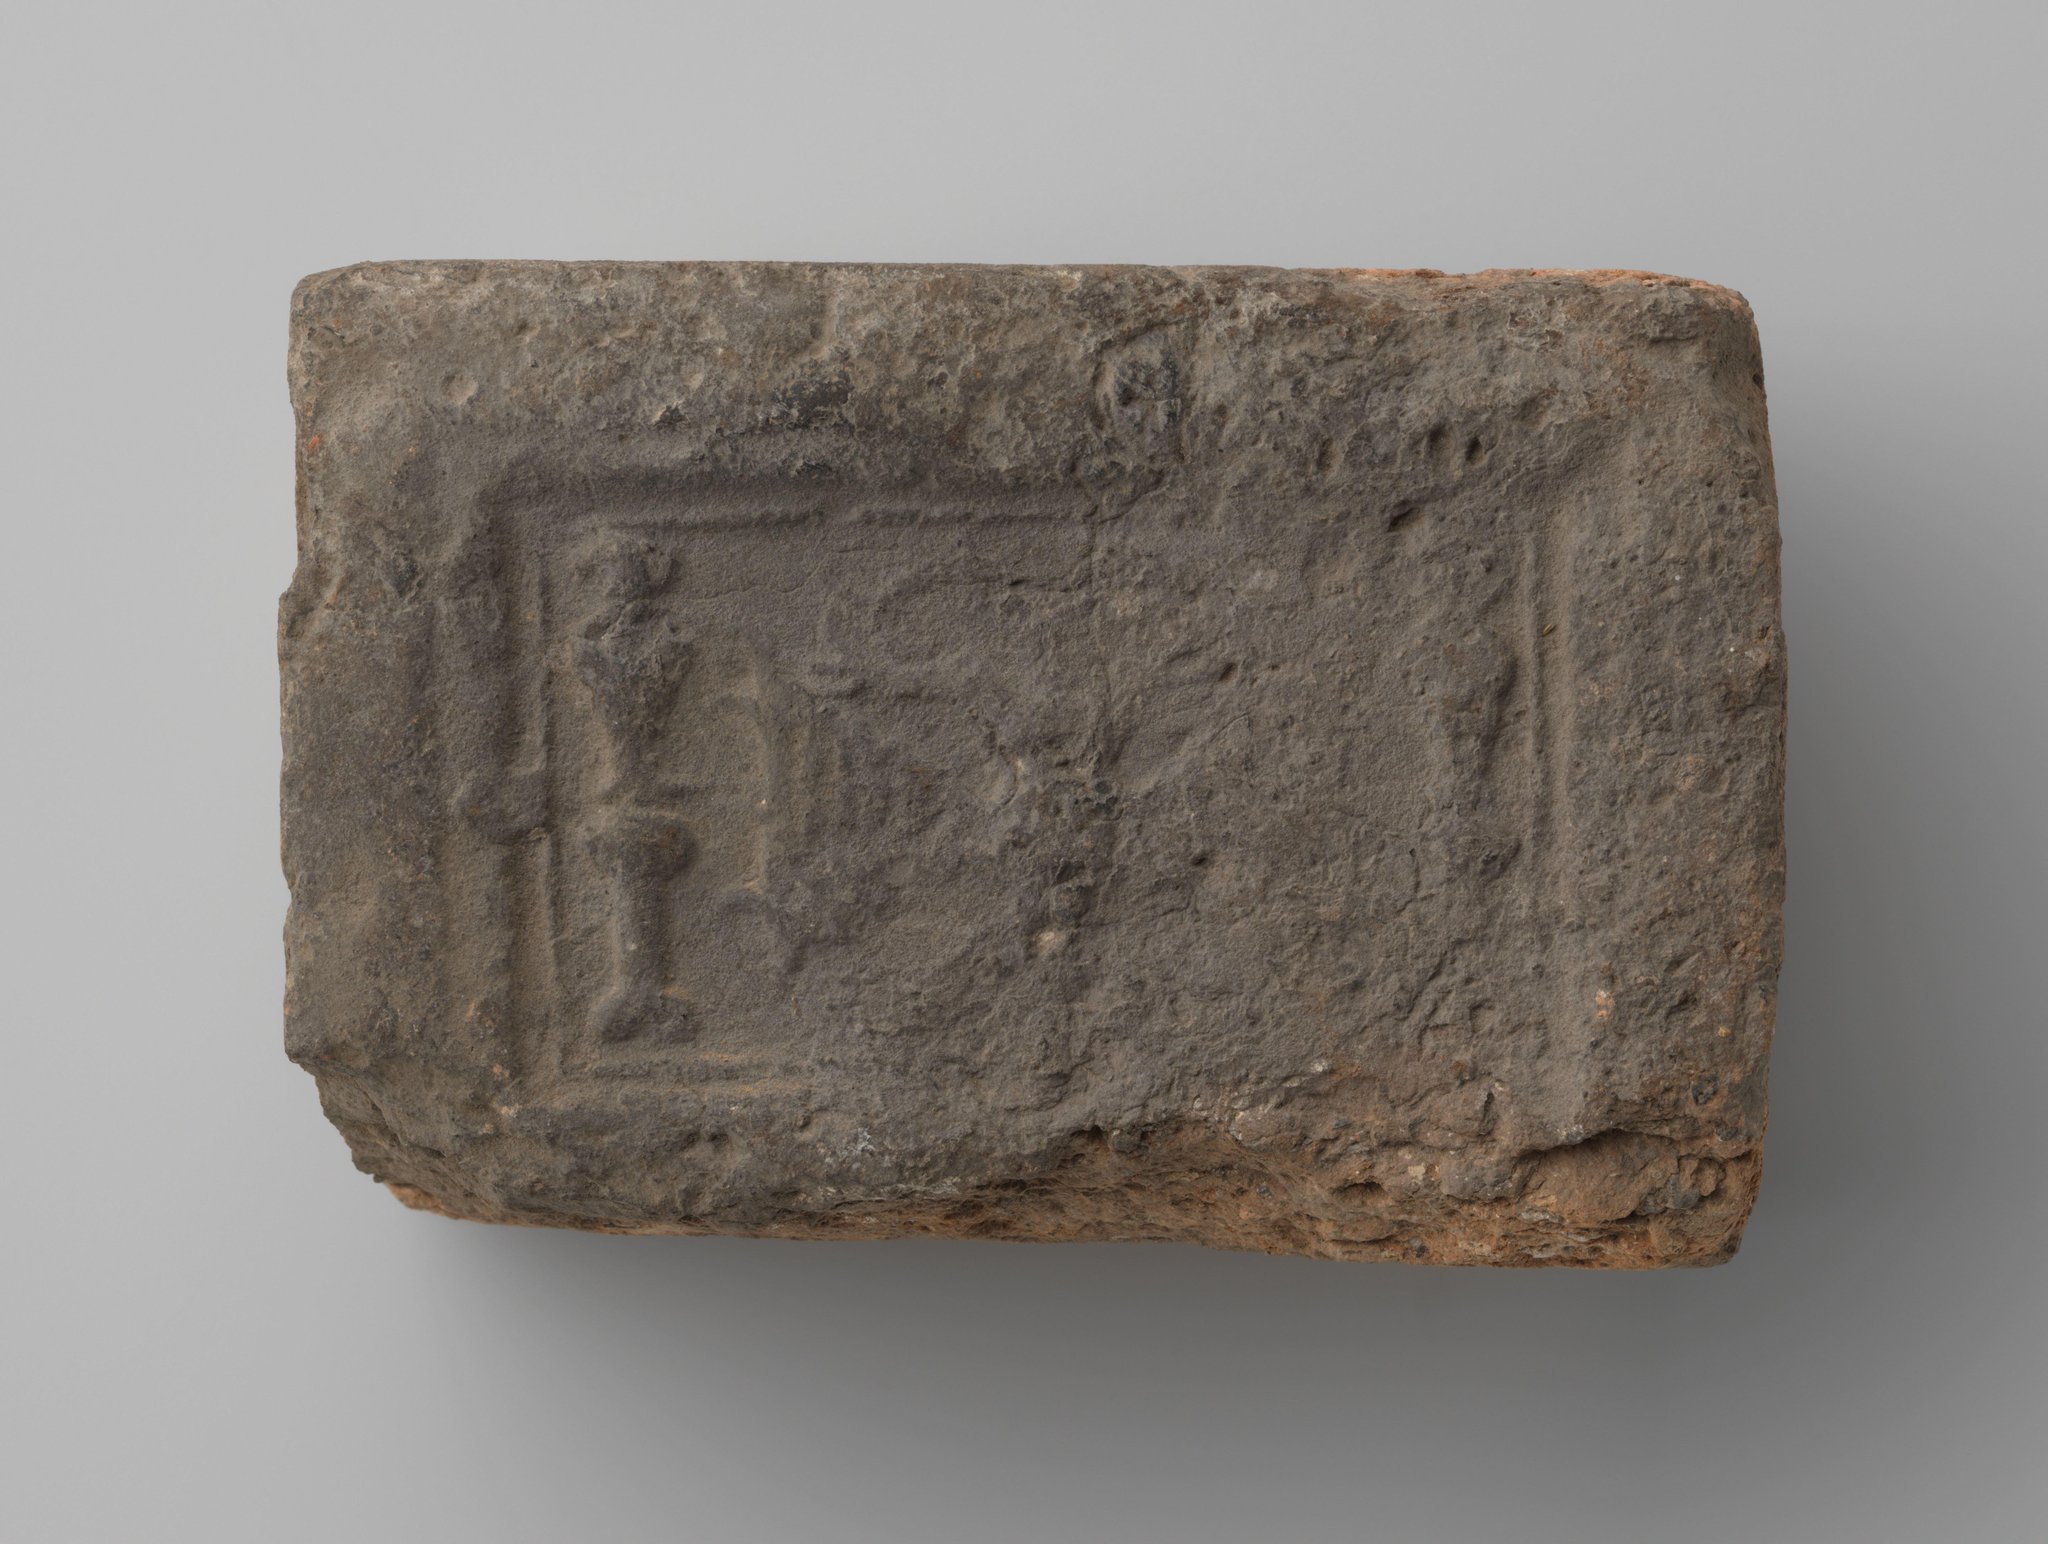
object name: hearthstone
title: Haardsteen met voorstelling van de tweekoppige adelaar tussen de zuilen van Hercules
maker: Anonymous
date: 1550-1600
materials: earthenware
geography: southern netherlands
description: Haardsteen met voorstelling van de tweekoppige adelaar tussen de zuilen van Hercules.